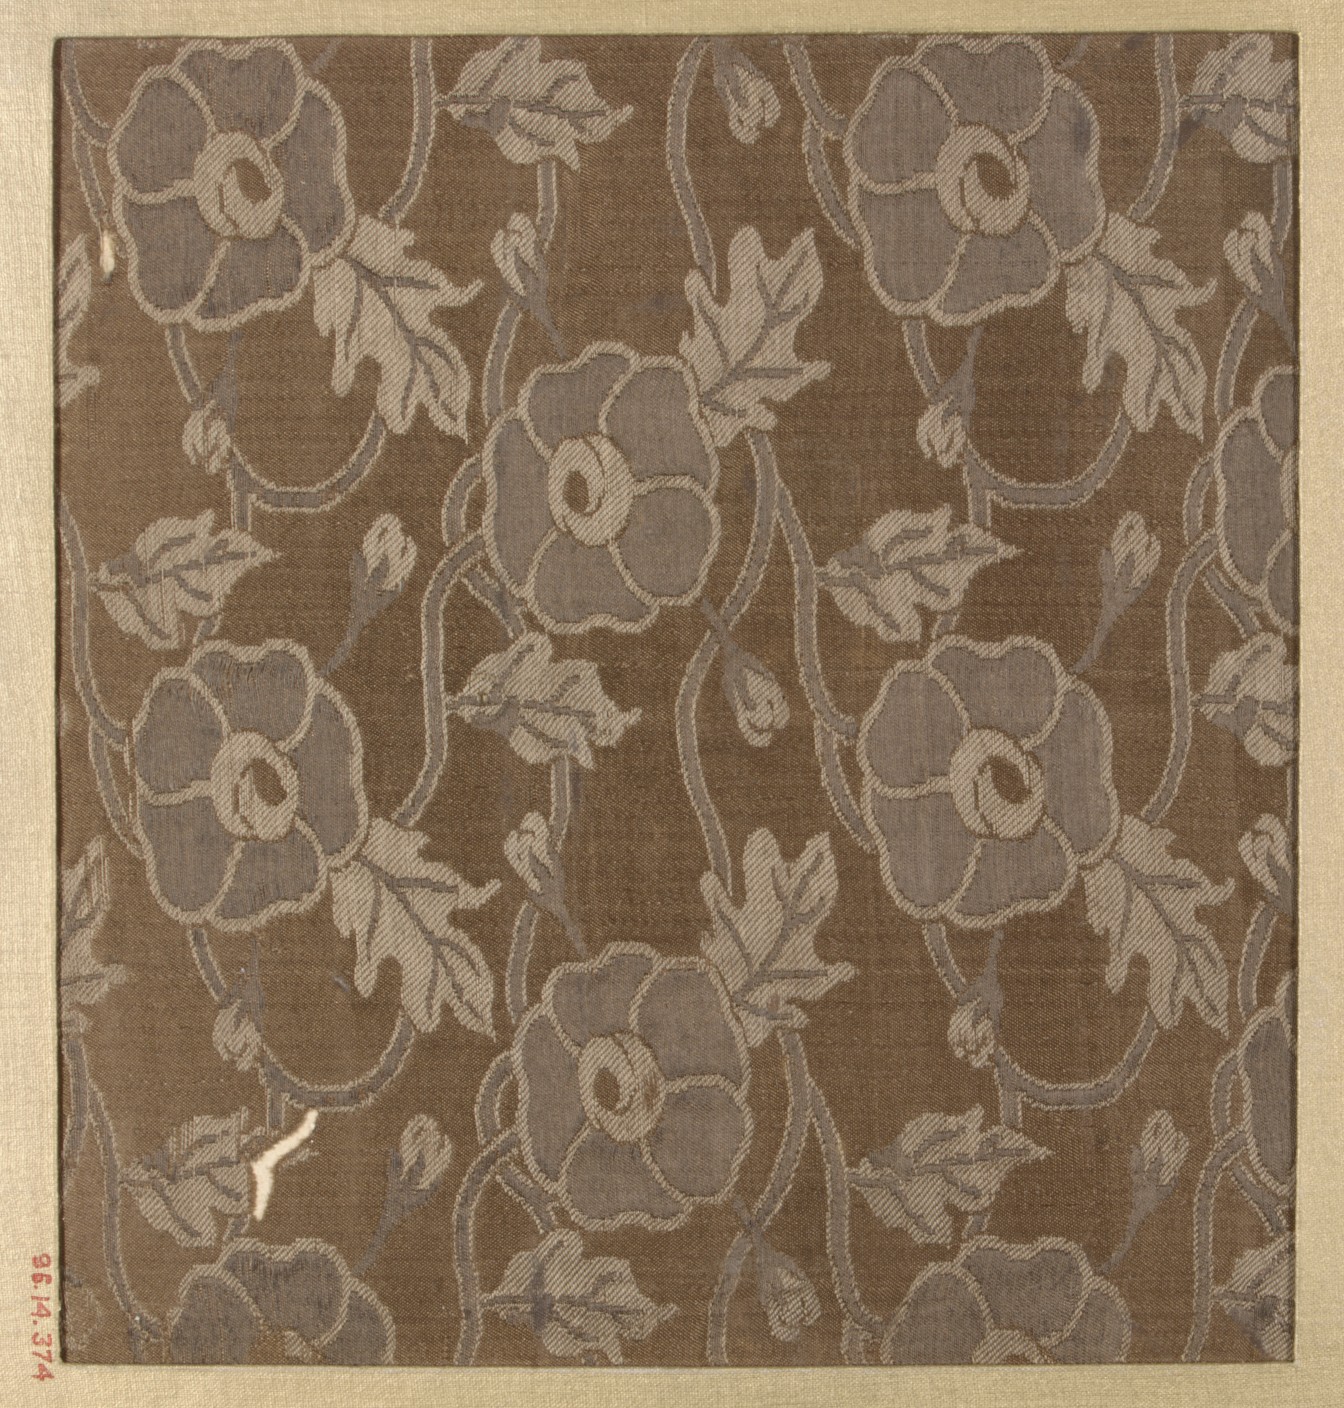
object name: piece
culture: japanese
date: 1701-1900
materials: silk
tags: flowers